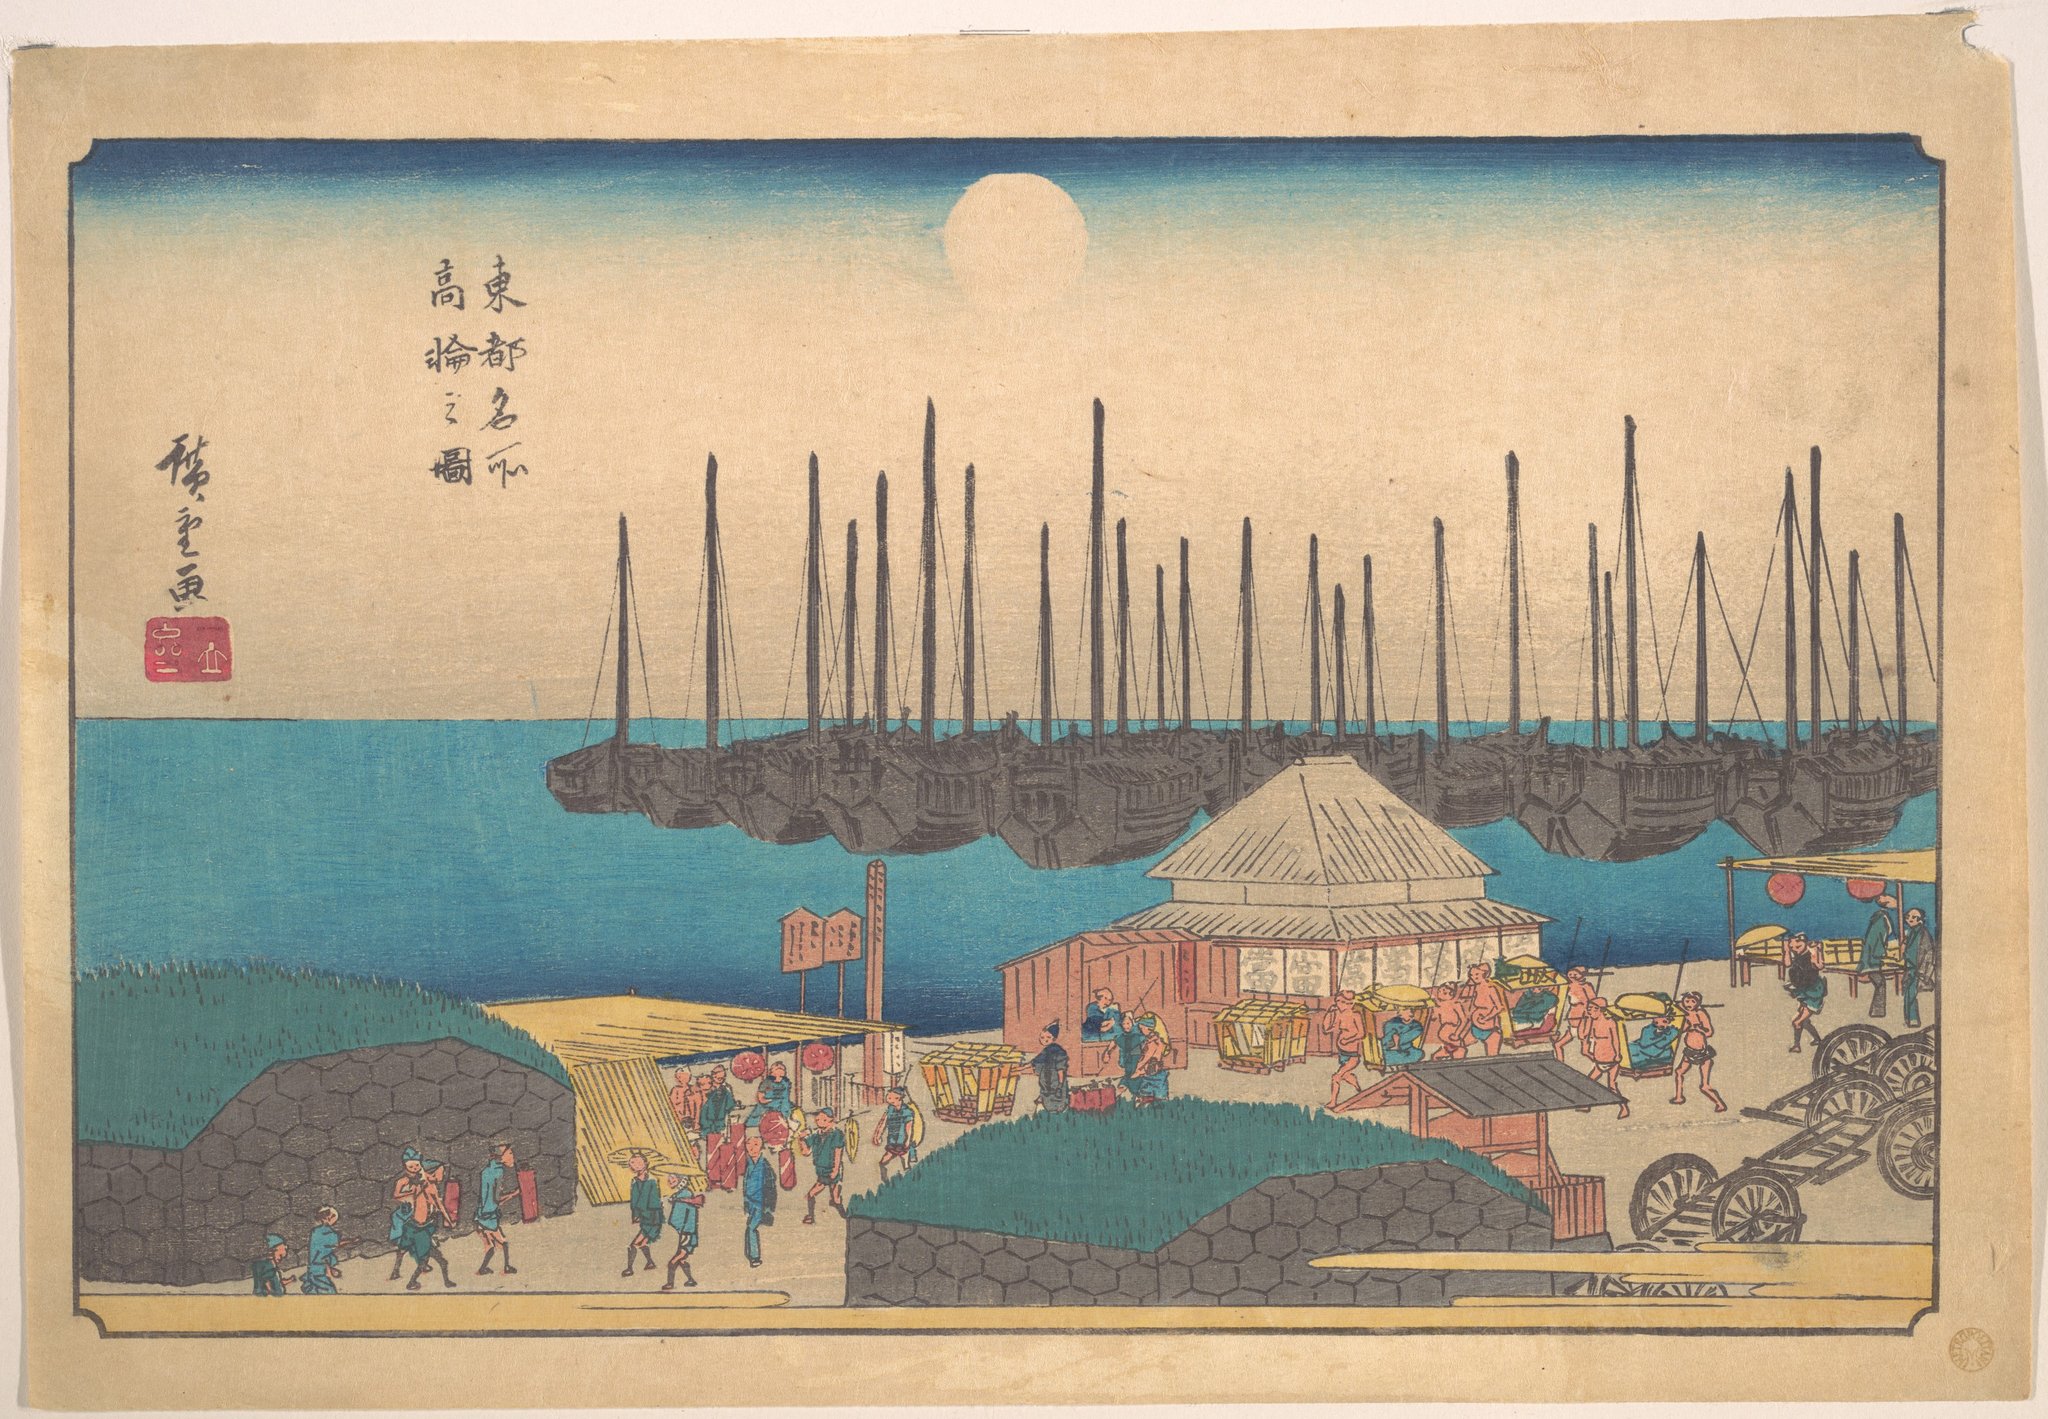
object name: print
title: Takanawa no Zu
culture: japanese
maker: utagawa hiroshige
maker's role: artist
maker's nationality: japanese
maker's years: 1797-1858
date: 1841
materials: ink, paper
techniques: woodblock print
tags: human figures,rivers,boats